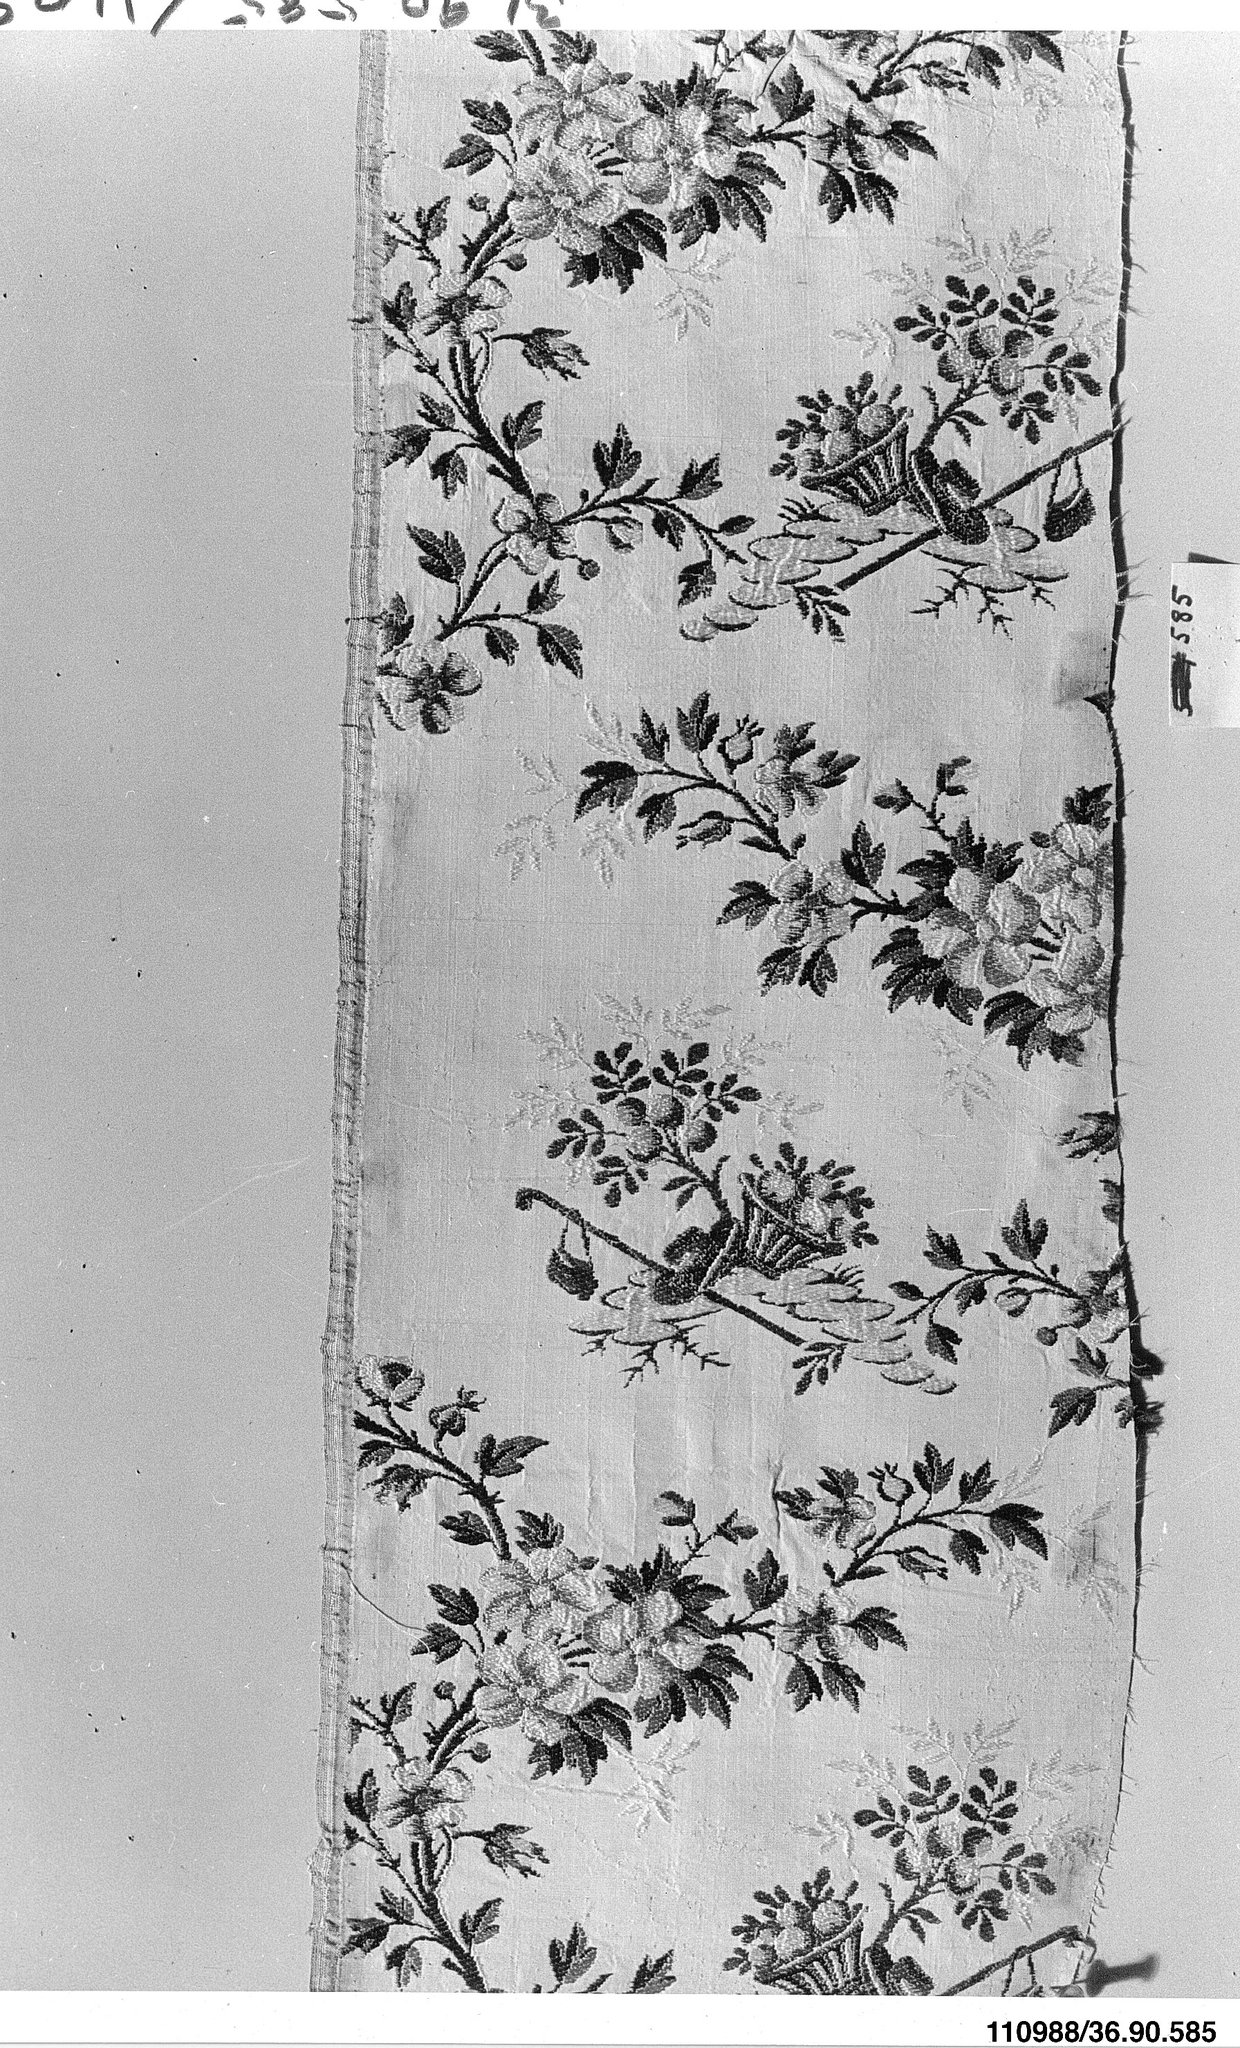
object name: piece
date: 1760-1770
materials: silk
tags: flowers,leaves